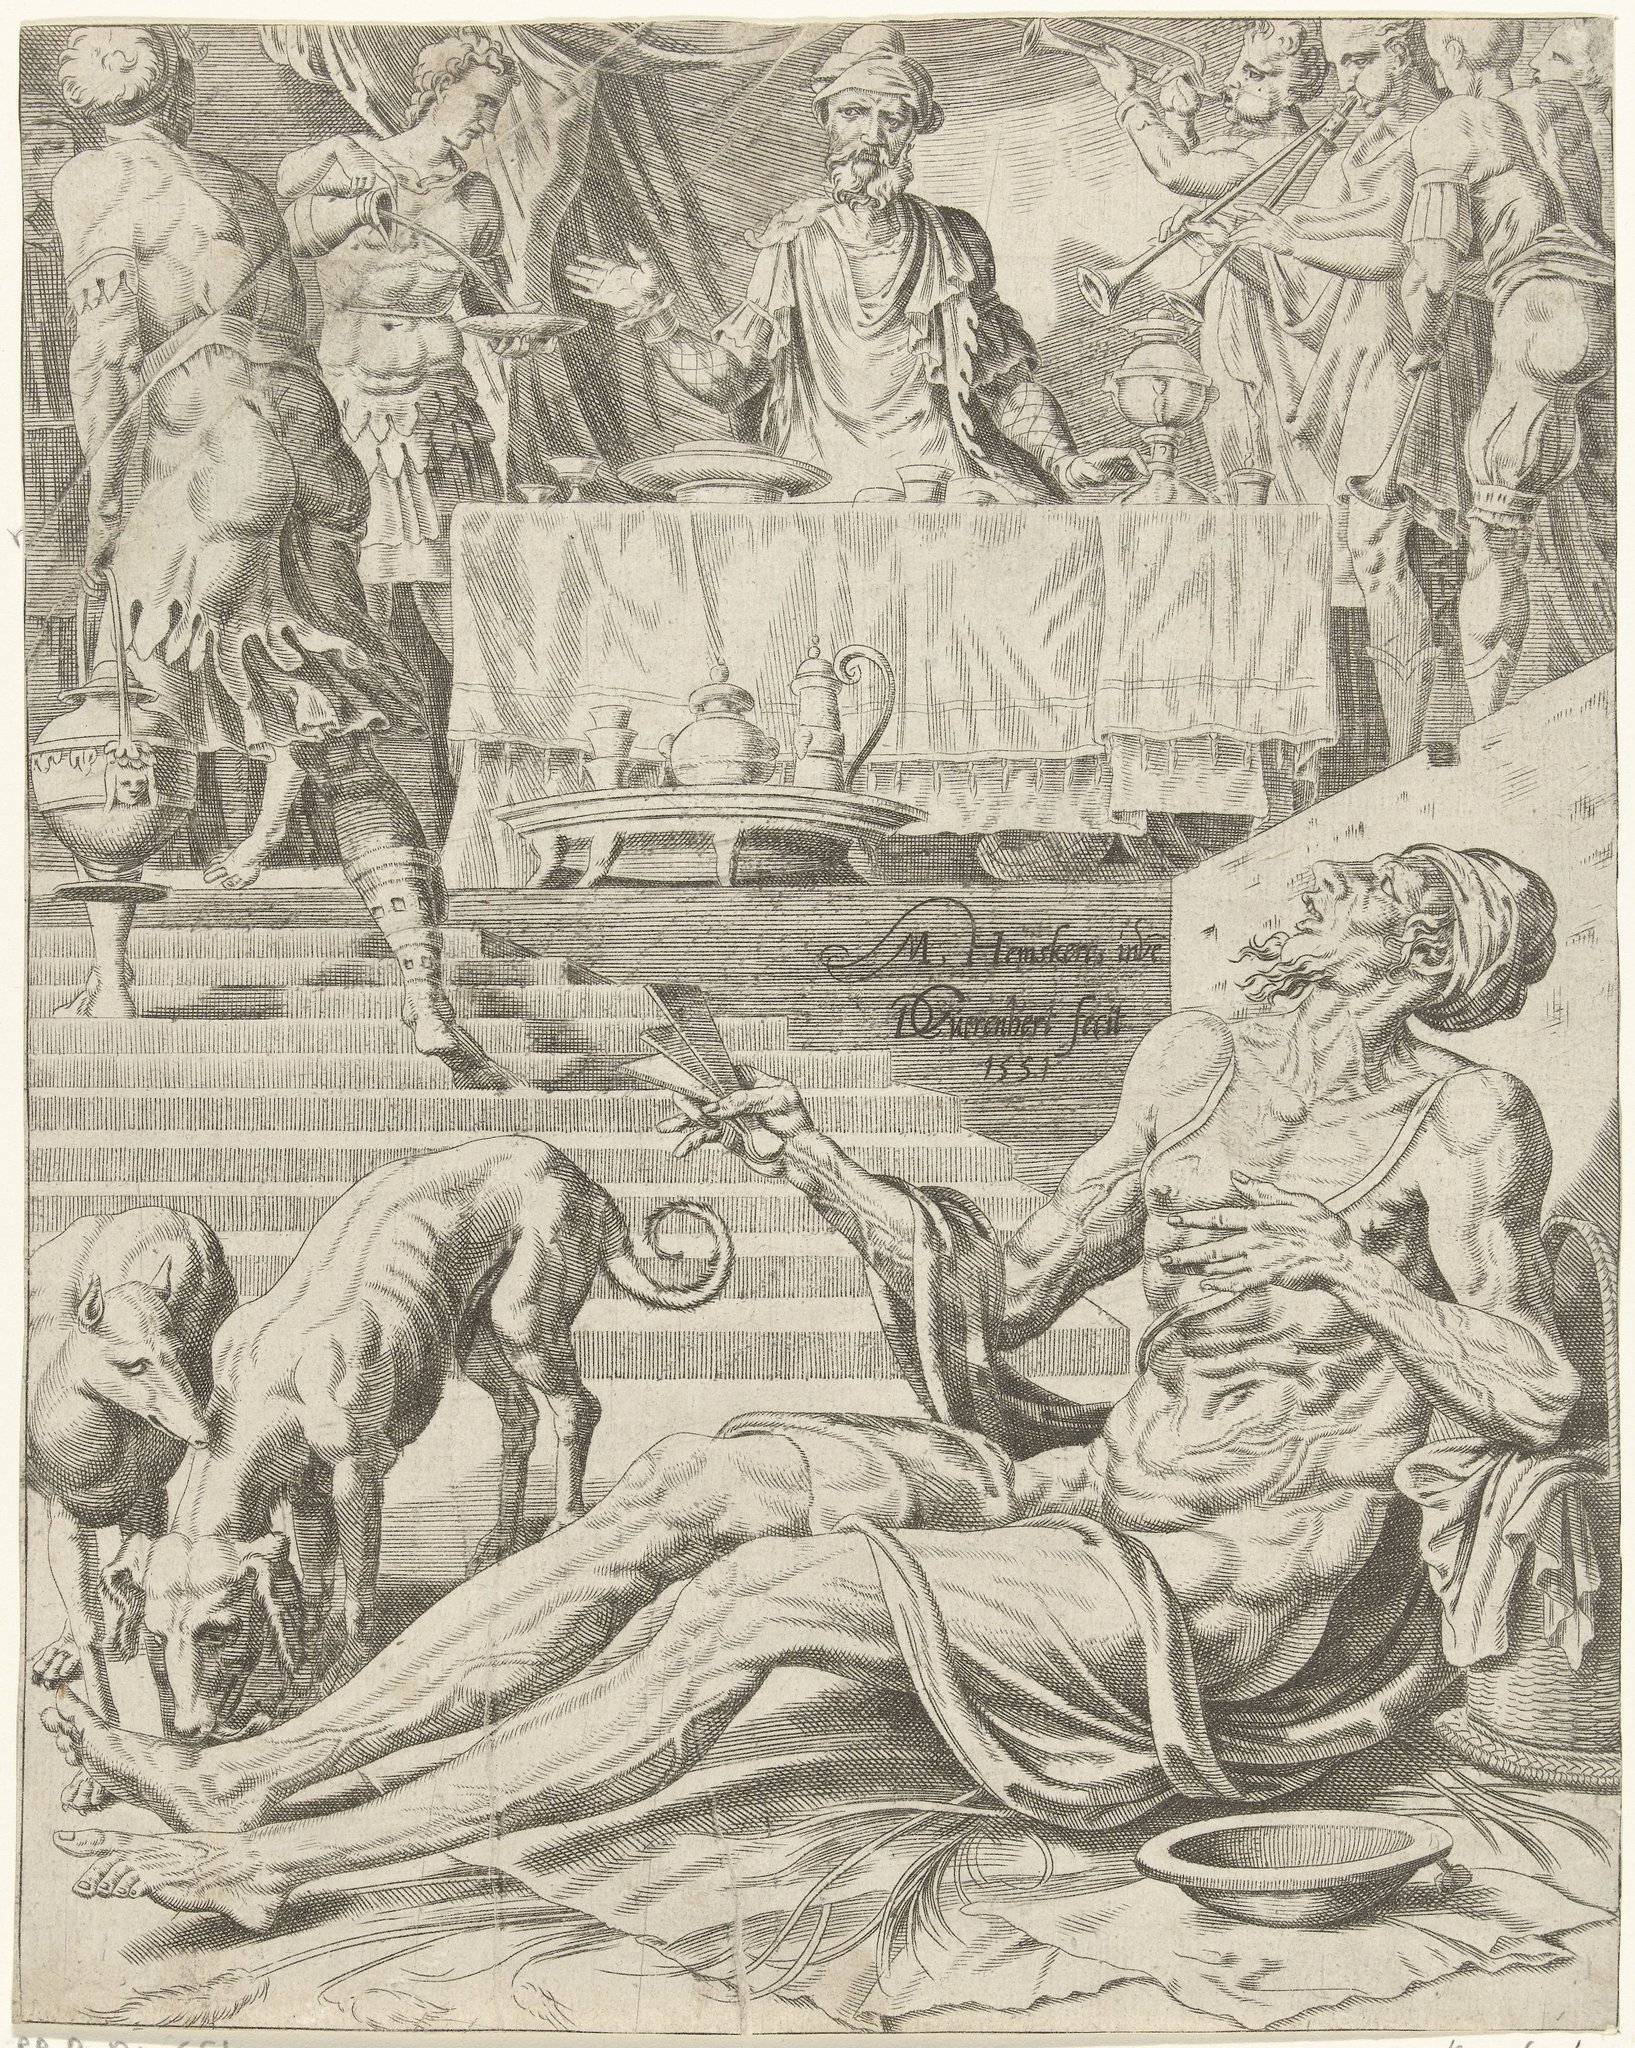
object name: print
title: Gelijkenis van de rijke man en de arme Lazarus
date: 1551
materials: paper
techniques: engraving, etching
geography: haarlem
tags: the rich man (dives) is feasting, while poor lazarus is starving at the gate (dogs licking lazarus' sores) (luke 16:19-31)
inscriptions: collector's mark: Lugt 2228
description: De rijke man zit aan een banket. Rechts van hem twee muzikanten die een blaasinstrument bespelen. Links vult een dienaar een schaal met wijn. Op de voorgrond ligt de arme Lazarus te bedelen.Twee honden likken zijn wonden. De prent maakt deel uit van een serie over gelijkenis van de rijke man en de arme Lazarus.